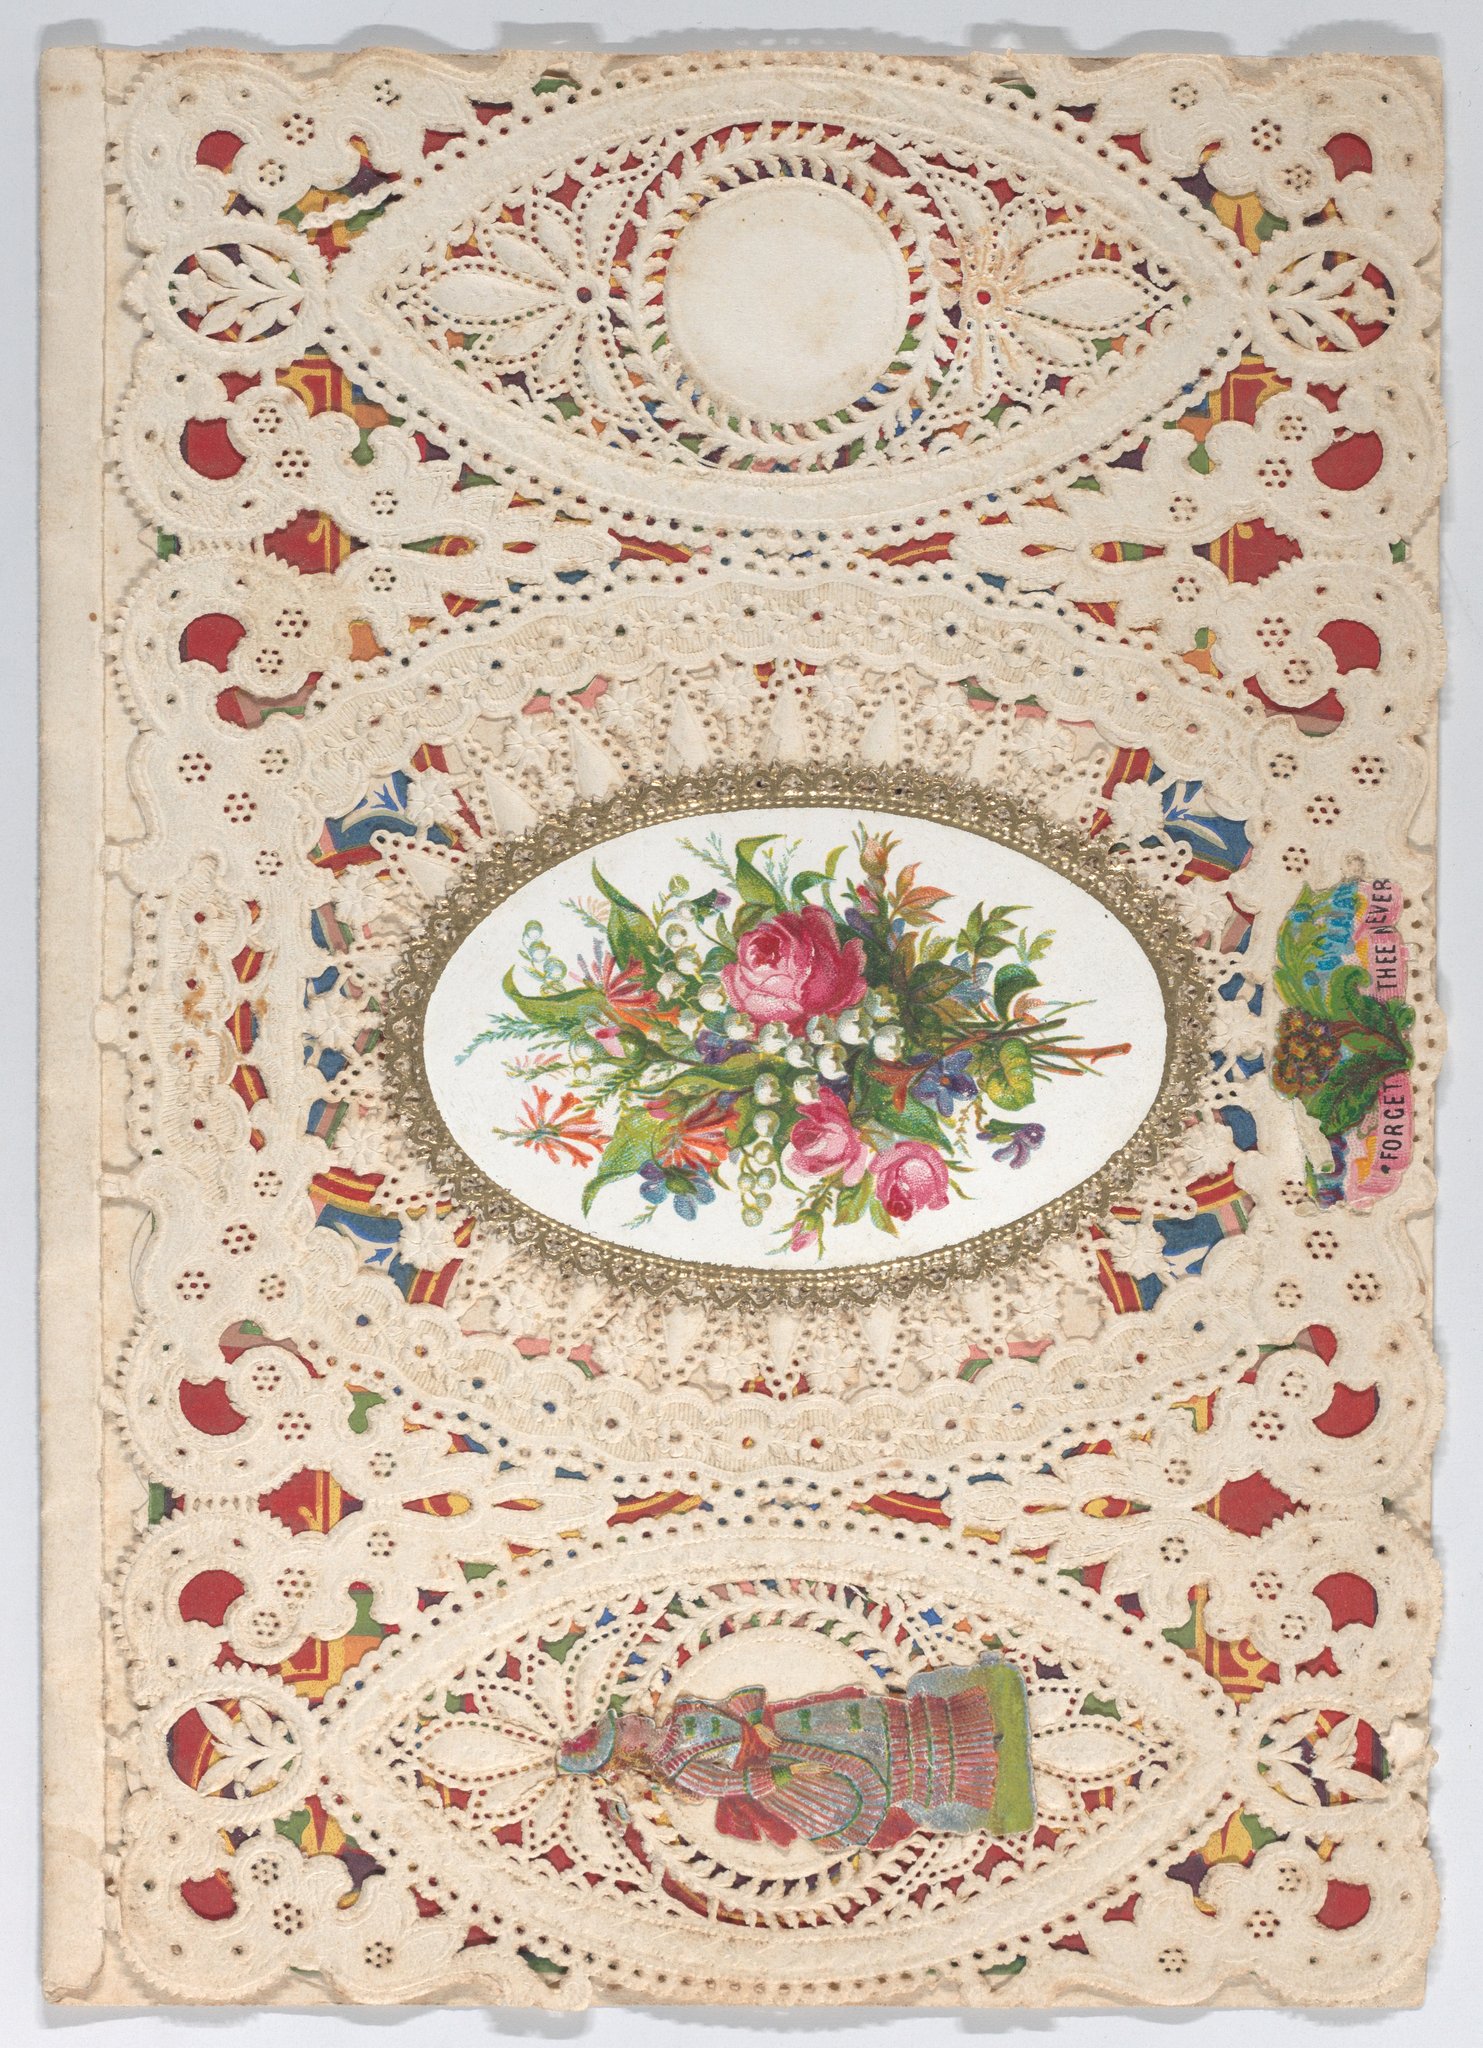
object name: valentine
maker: Anonymous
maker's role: artist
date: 1880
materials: lace, paper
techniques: chromolithography, cutting, embossing, gilding, open work